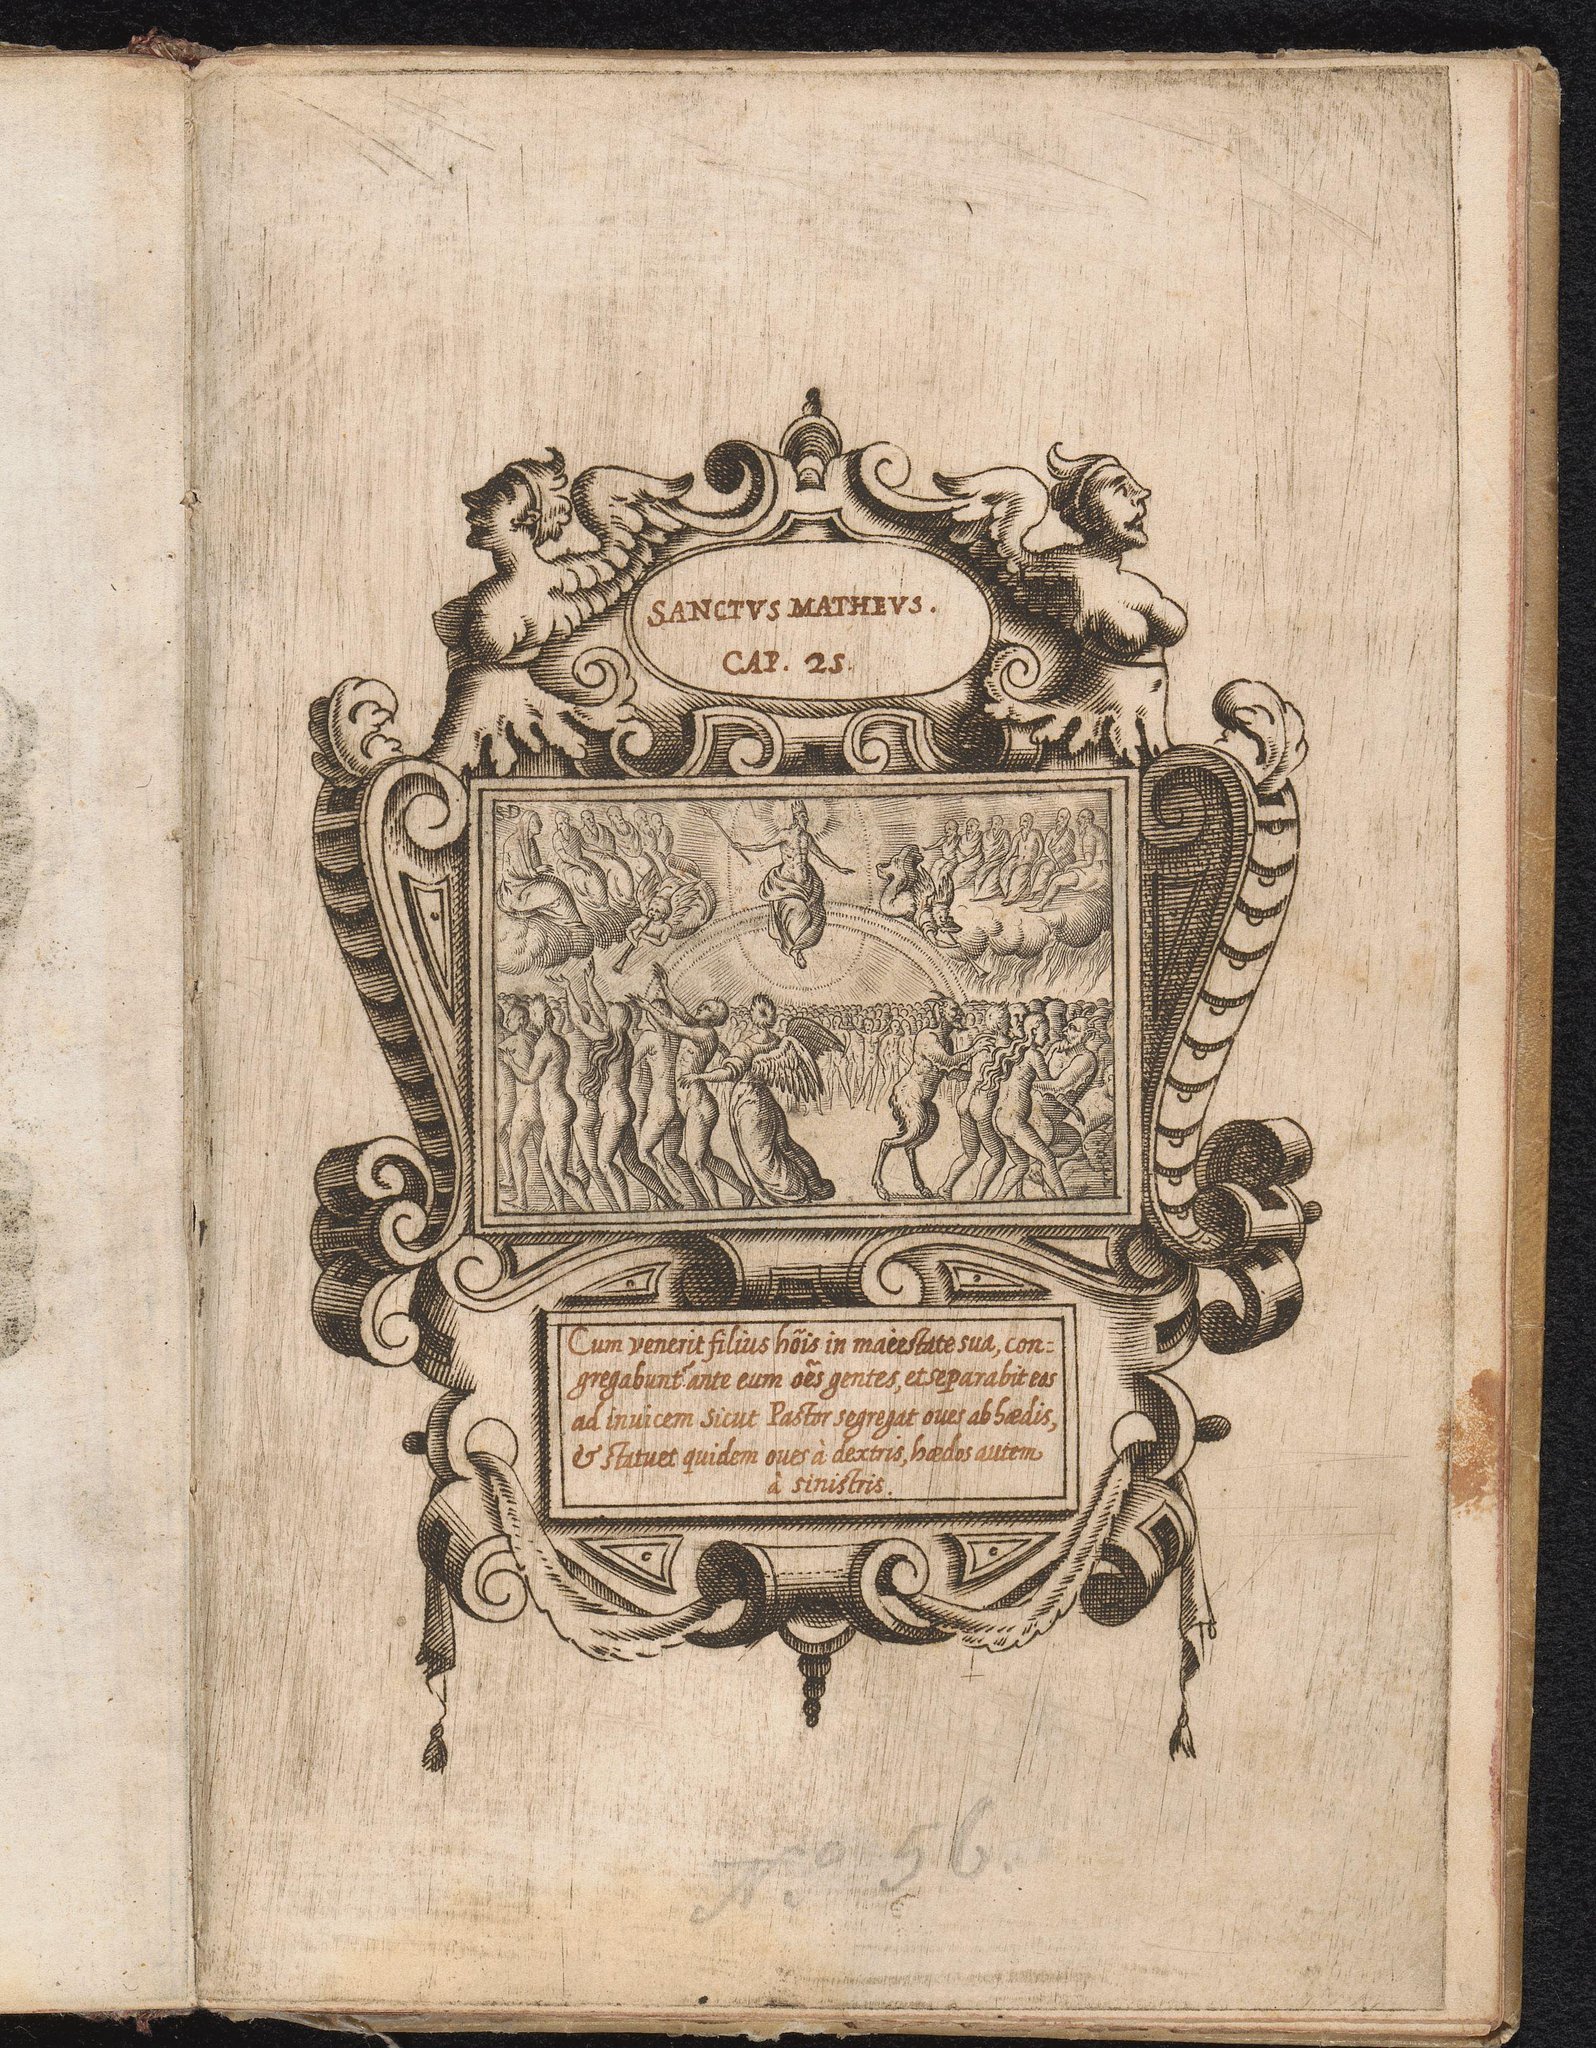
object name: print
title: Laatste Oordeel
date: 1570-1610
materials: paper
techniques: engraving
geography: antwerp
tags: comprehensive representation of last judgement: christ (with sword and lily), often surrounded by elders and sometimes accompanied by mary and john the baptist, appears in the sky with trumpeting angels (and sometimes angels holding the instruments of the passion); after the resurrection of the dead the blessed are led to heaven by angels, and the damned are dragged into hell by devils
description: Laatste Oordeel. Onderdeel van een prentalbum met titelprent en 56 scènes uit het Nieuwe Testament. Elke voorstelling gemonteerd in een gravure met ornamentele cartouches waarin een venster is gesneden en voorzien van handgeschreven bijbelpassages.